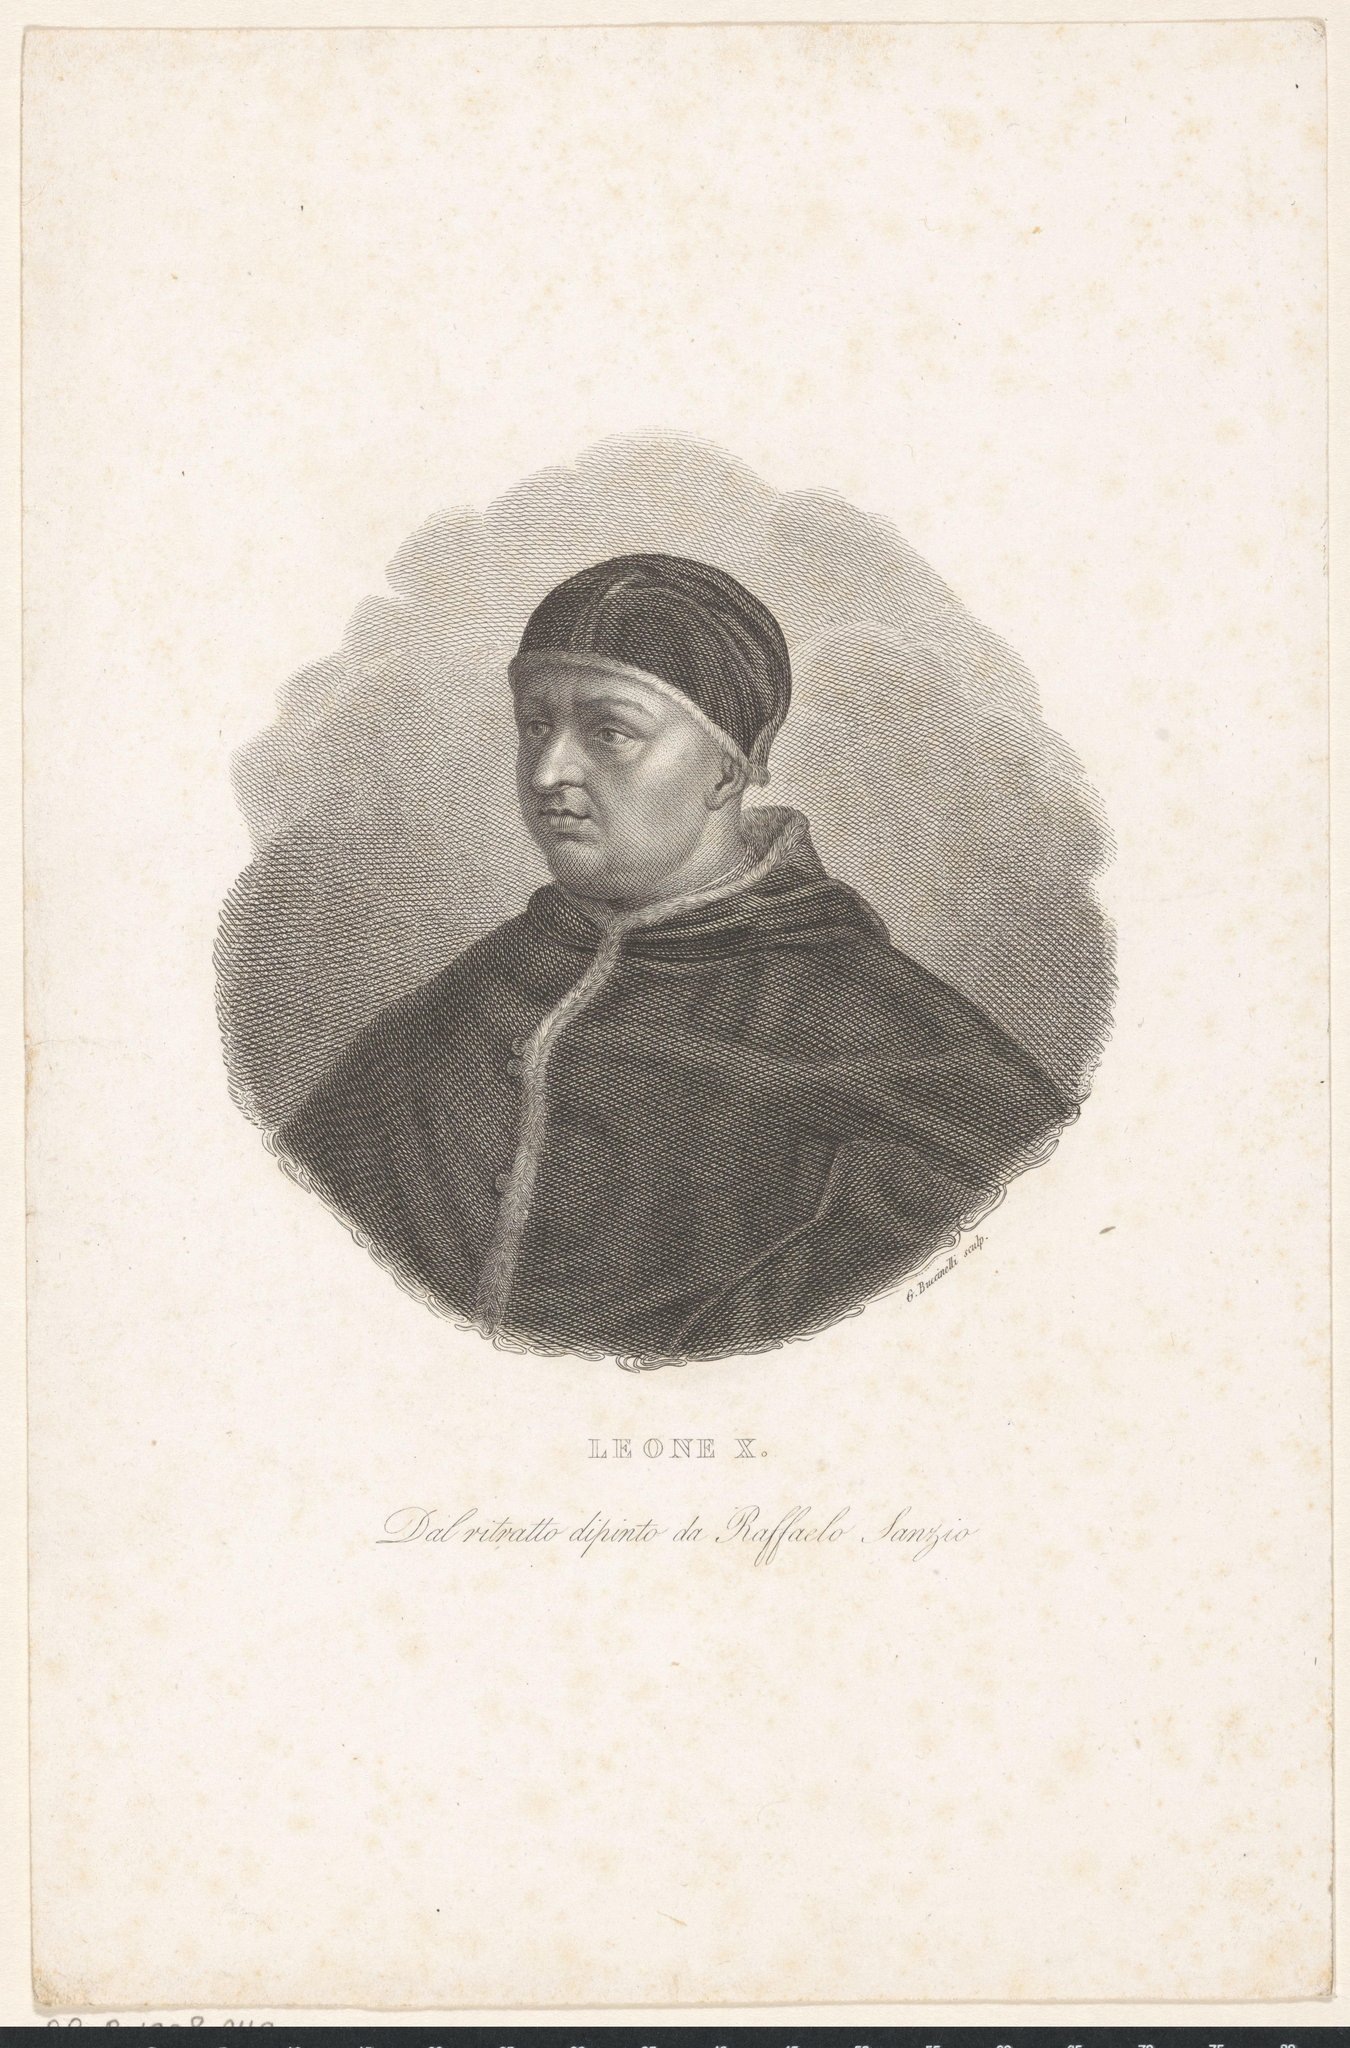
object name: print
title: Portret van paus Leo X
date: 1800-1899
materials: paper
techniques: engraving, etching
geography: italy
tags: rome, leo x, historical persons, pope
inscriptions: collector's mark: Lugt 2228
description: Naar een schilderij van Rafaël in de Galleria degli Uffizi te Florence.